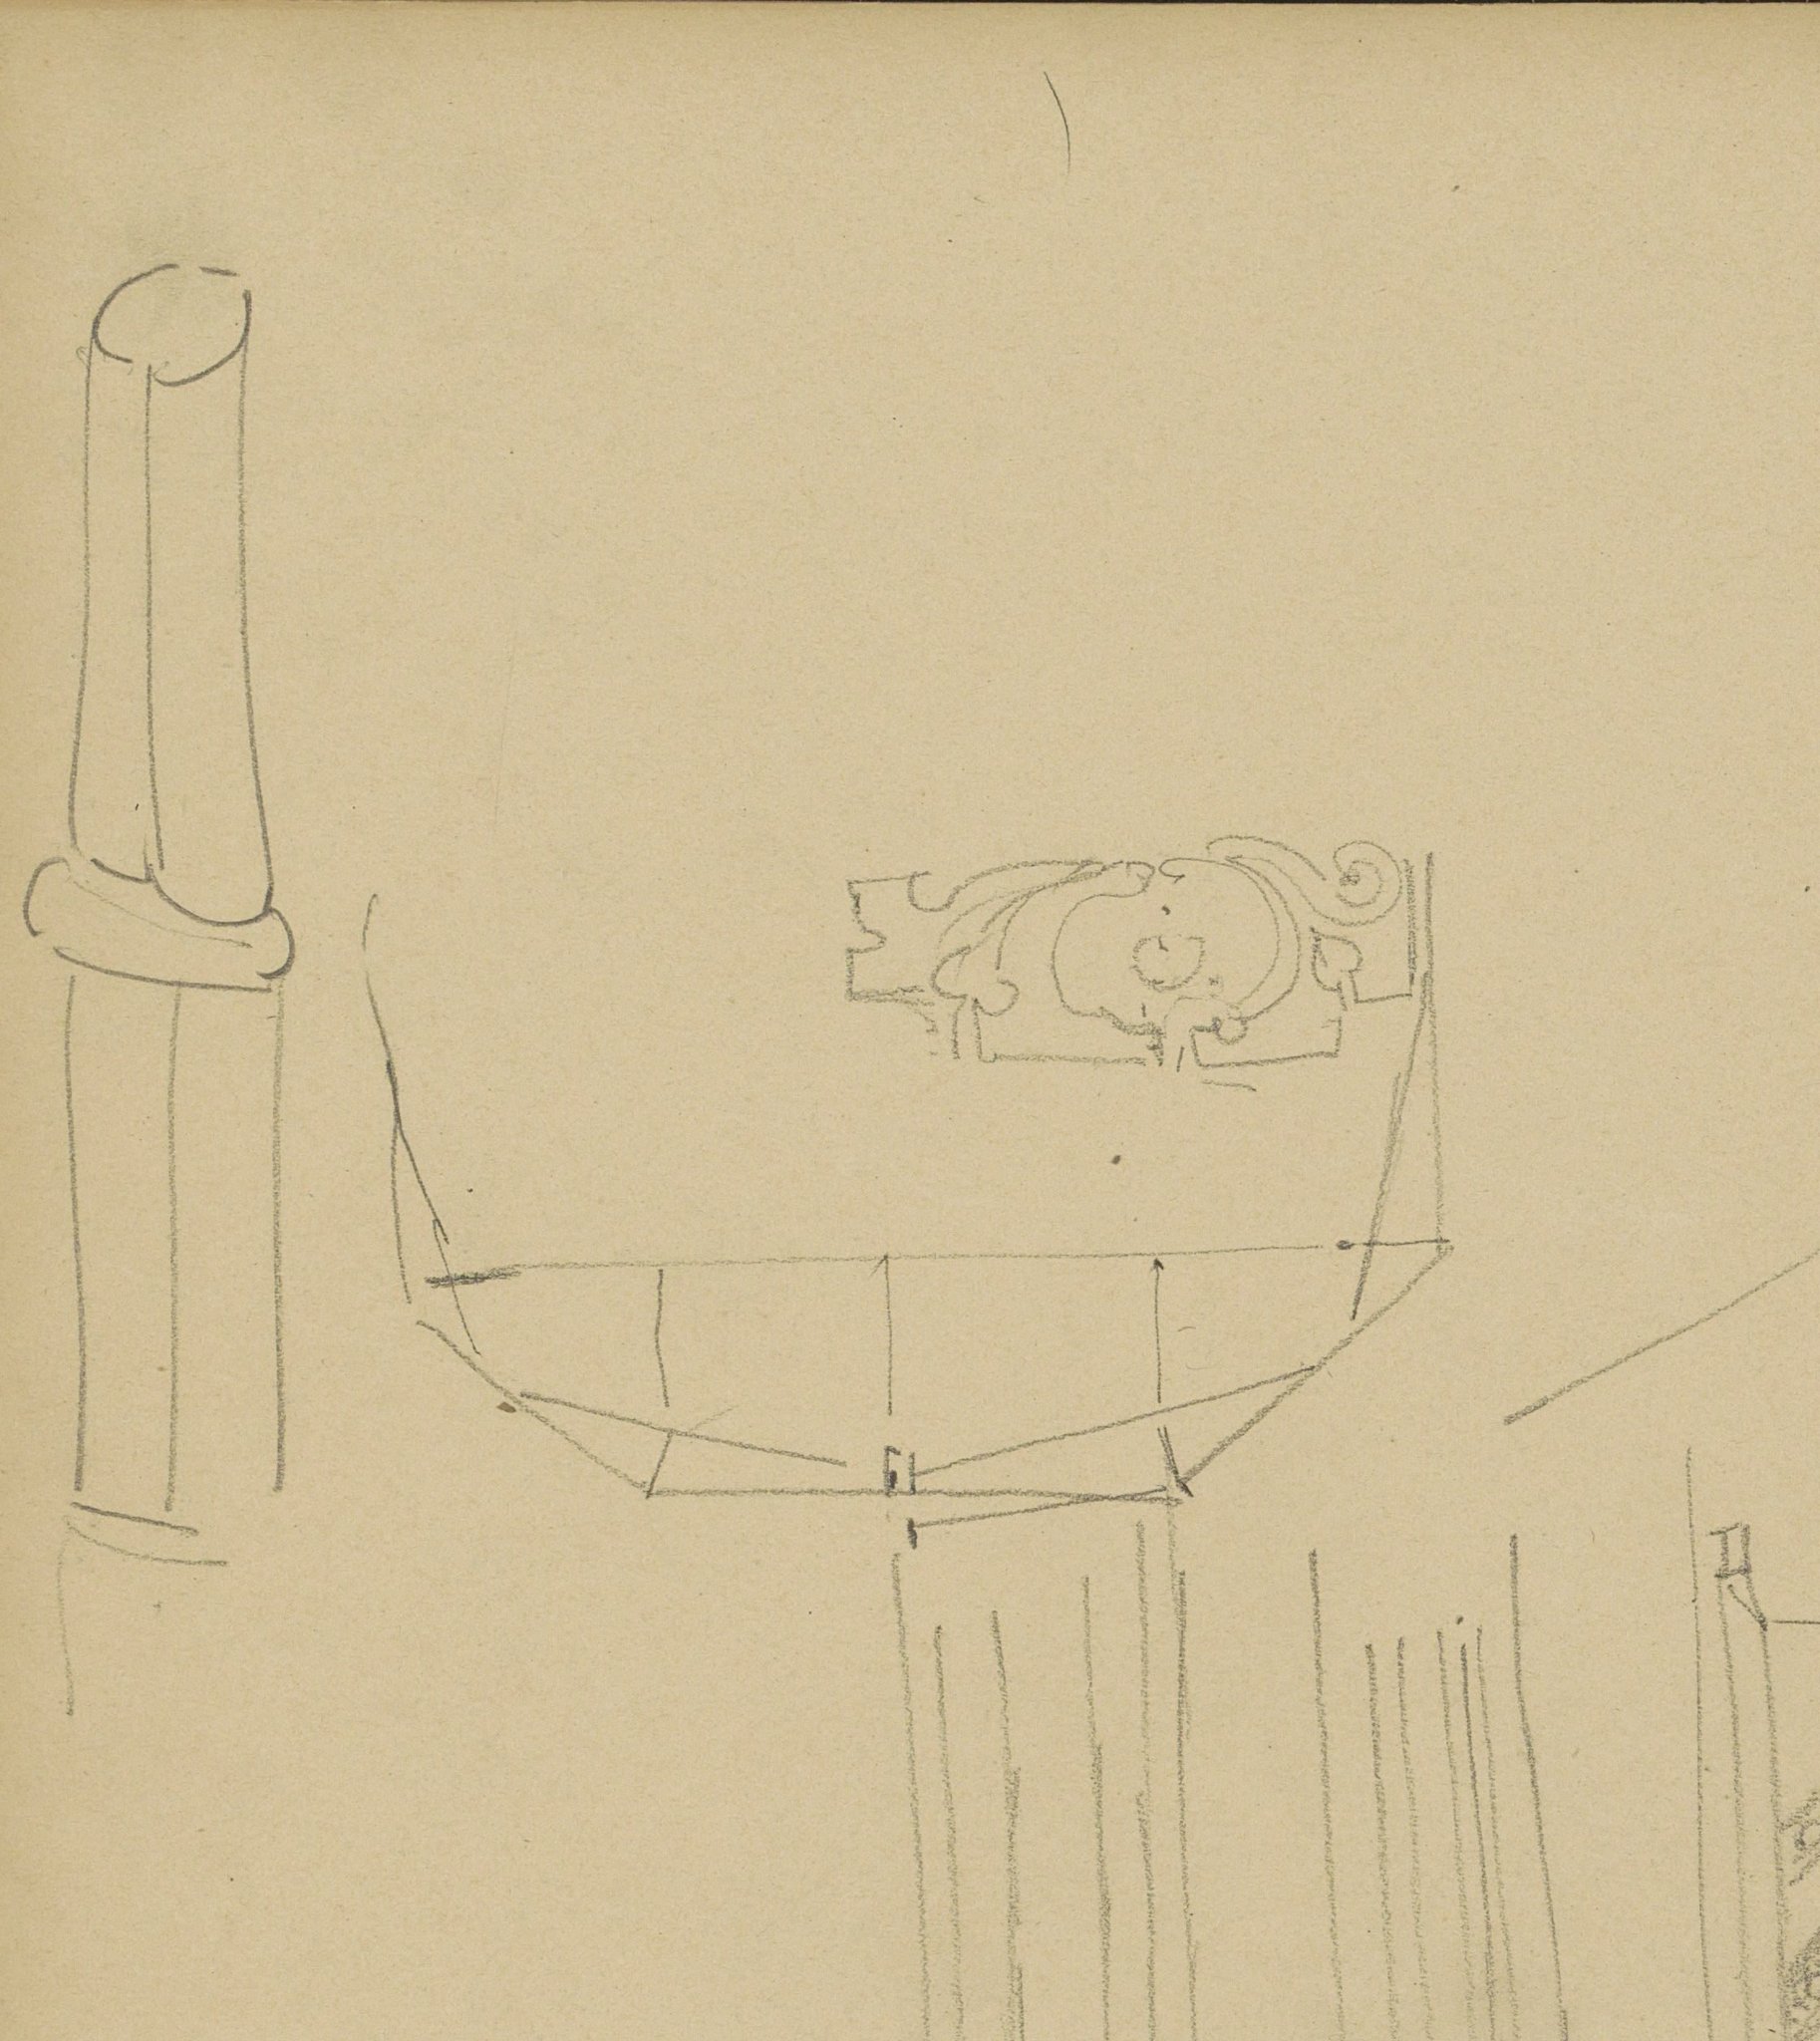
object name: sketchbook leaf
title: Ontwerpen voor wanddecoratie en architectuurstudies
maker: carel adolph lion cachet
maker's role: draughtsman, print maker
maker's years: 1864-1945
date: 1906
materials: paper, pencil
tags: architecture, wall-covering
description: Blad 19 verso uit een schetsboek met 27 bladen.